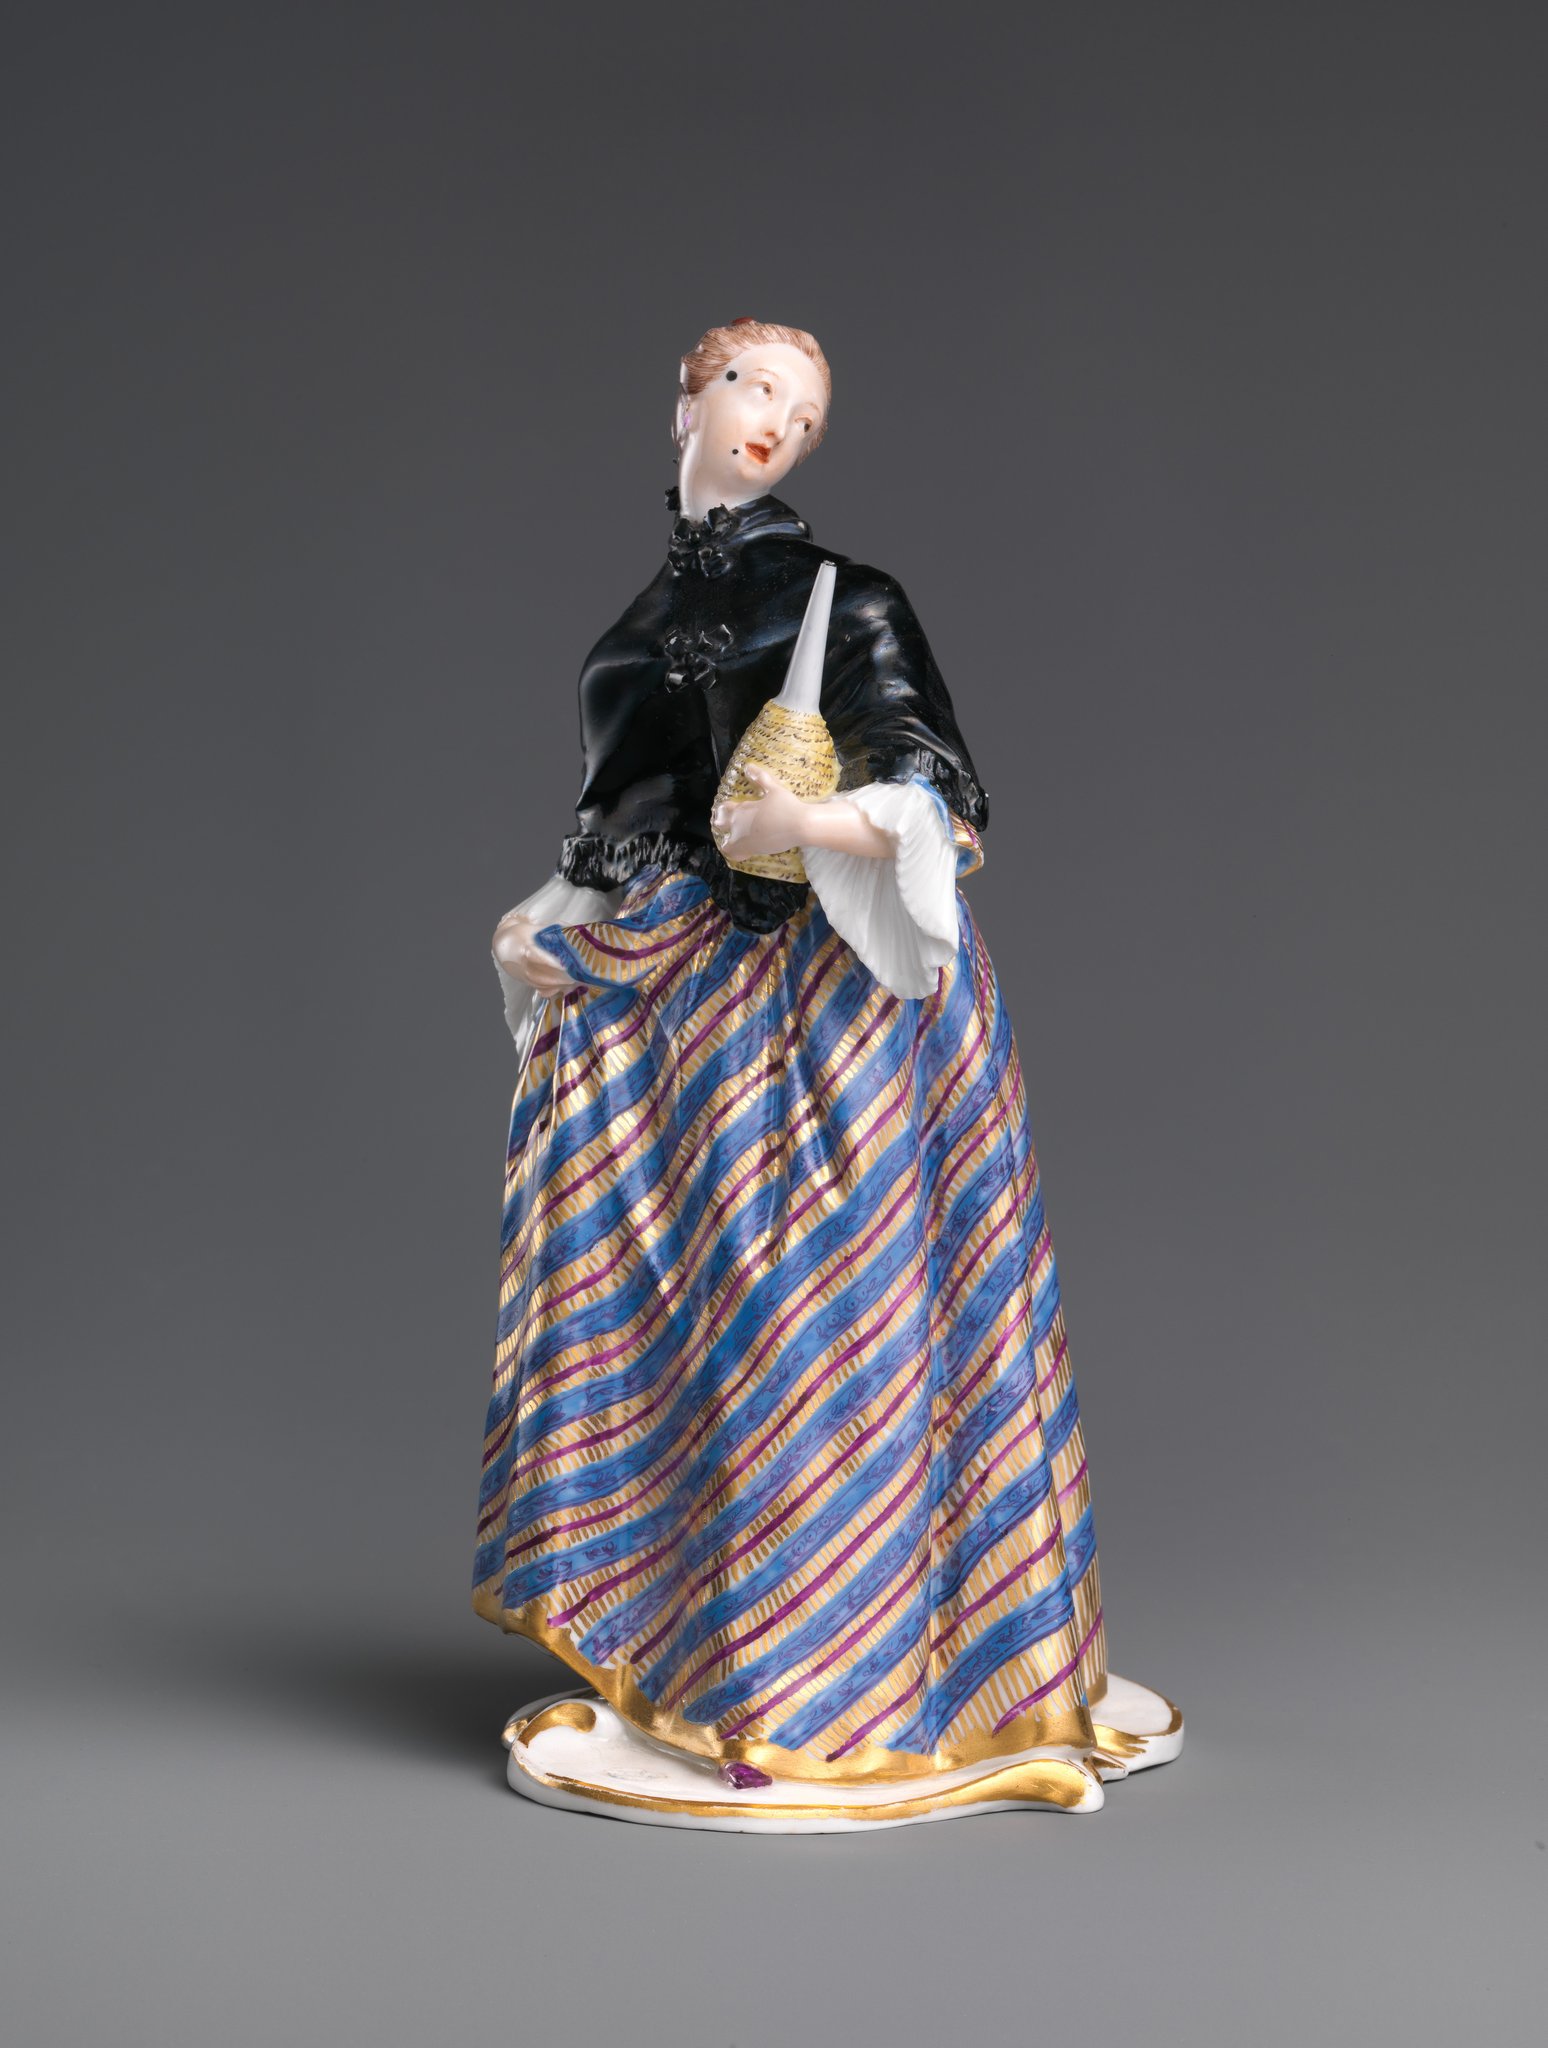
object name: figure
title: Donna Martina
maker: nymphenburg porcelain manufactory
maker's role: manufactory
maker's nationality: german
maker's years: 1747-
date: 1760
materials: hard paste porcelain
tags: women